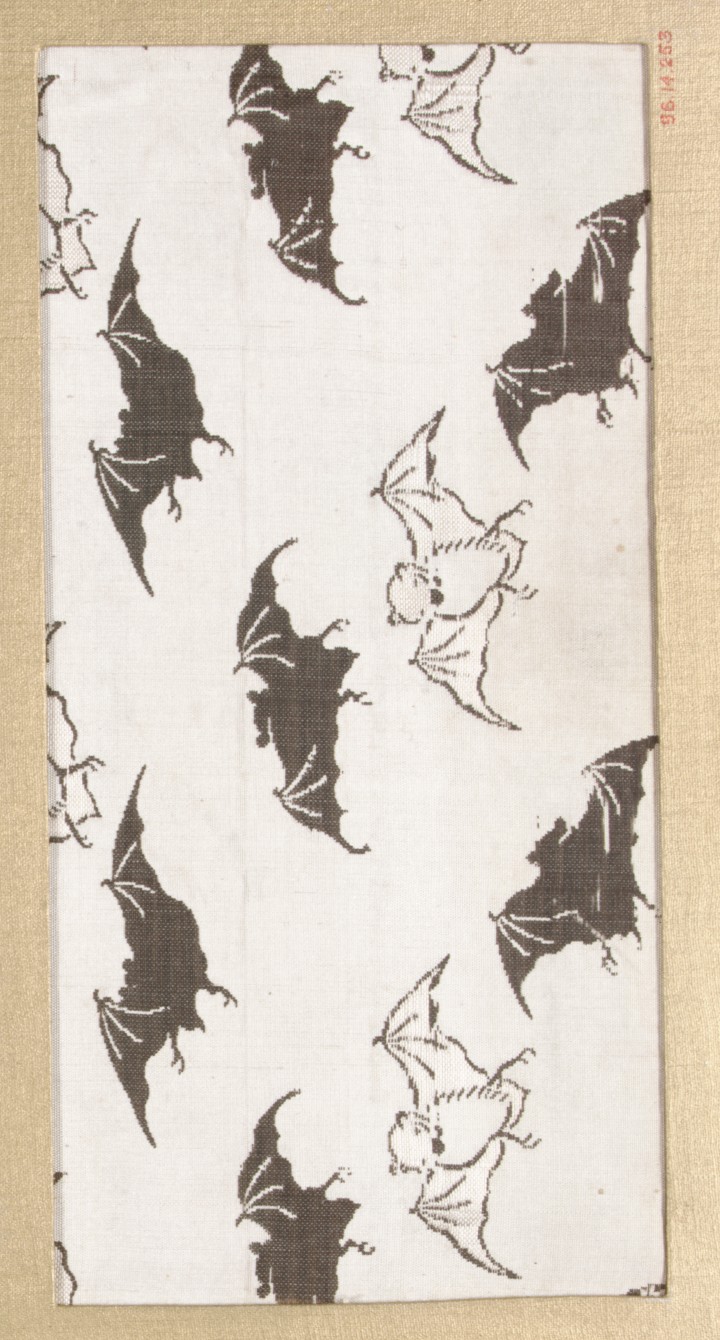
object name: piece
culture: japanese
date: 1701-1900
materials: silk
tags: bats